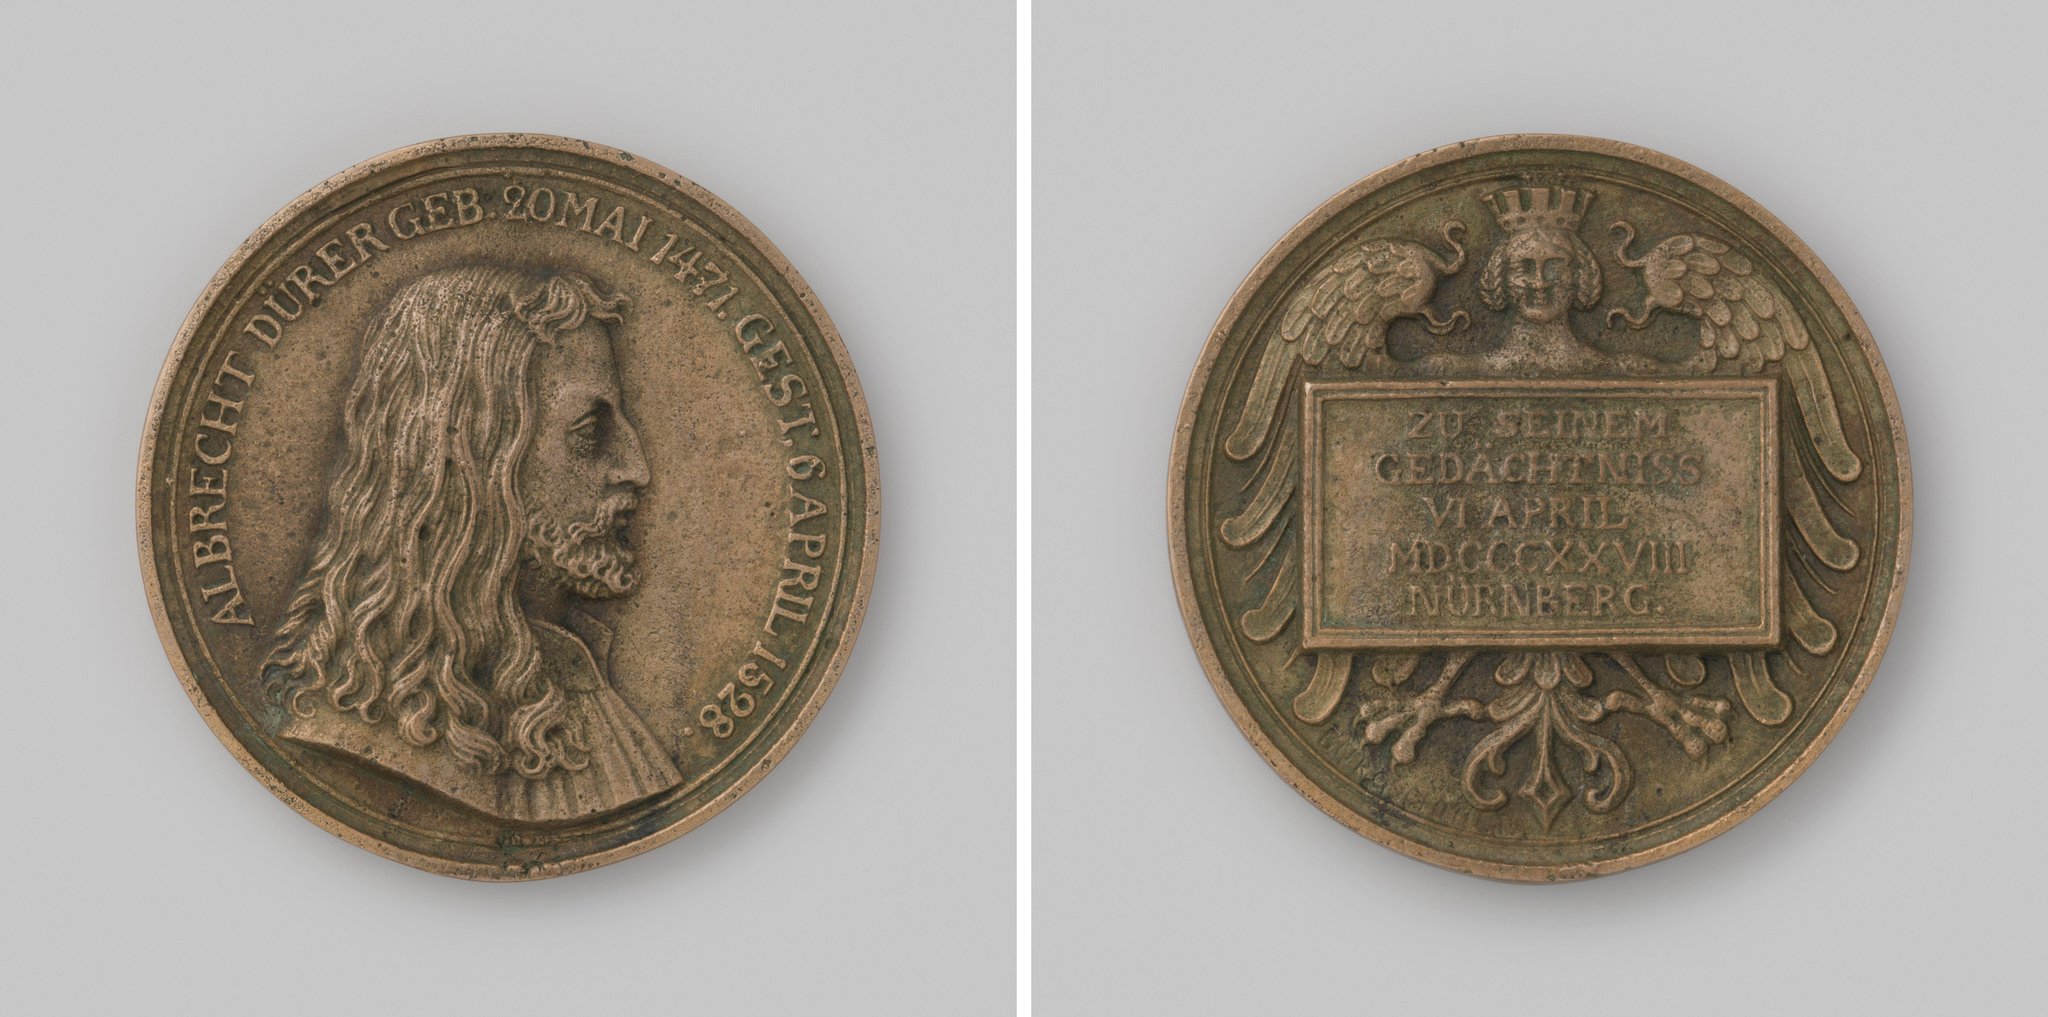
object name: history medal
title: Driehonderdjarige herdenking van het overlijden van Albrecht Durer, penning geslagen door de stad Neurenberg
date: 1828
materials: copper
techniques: casting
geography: germany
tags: painter, print maker, draughtsman, albrecht dürer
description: Koperen penning. Voorzijde: borststuk man binnen omschrift. Keerzijde: adelaar met gekroonde vrouwenkop houdt rechthoekig tableau met opschrift voor borst